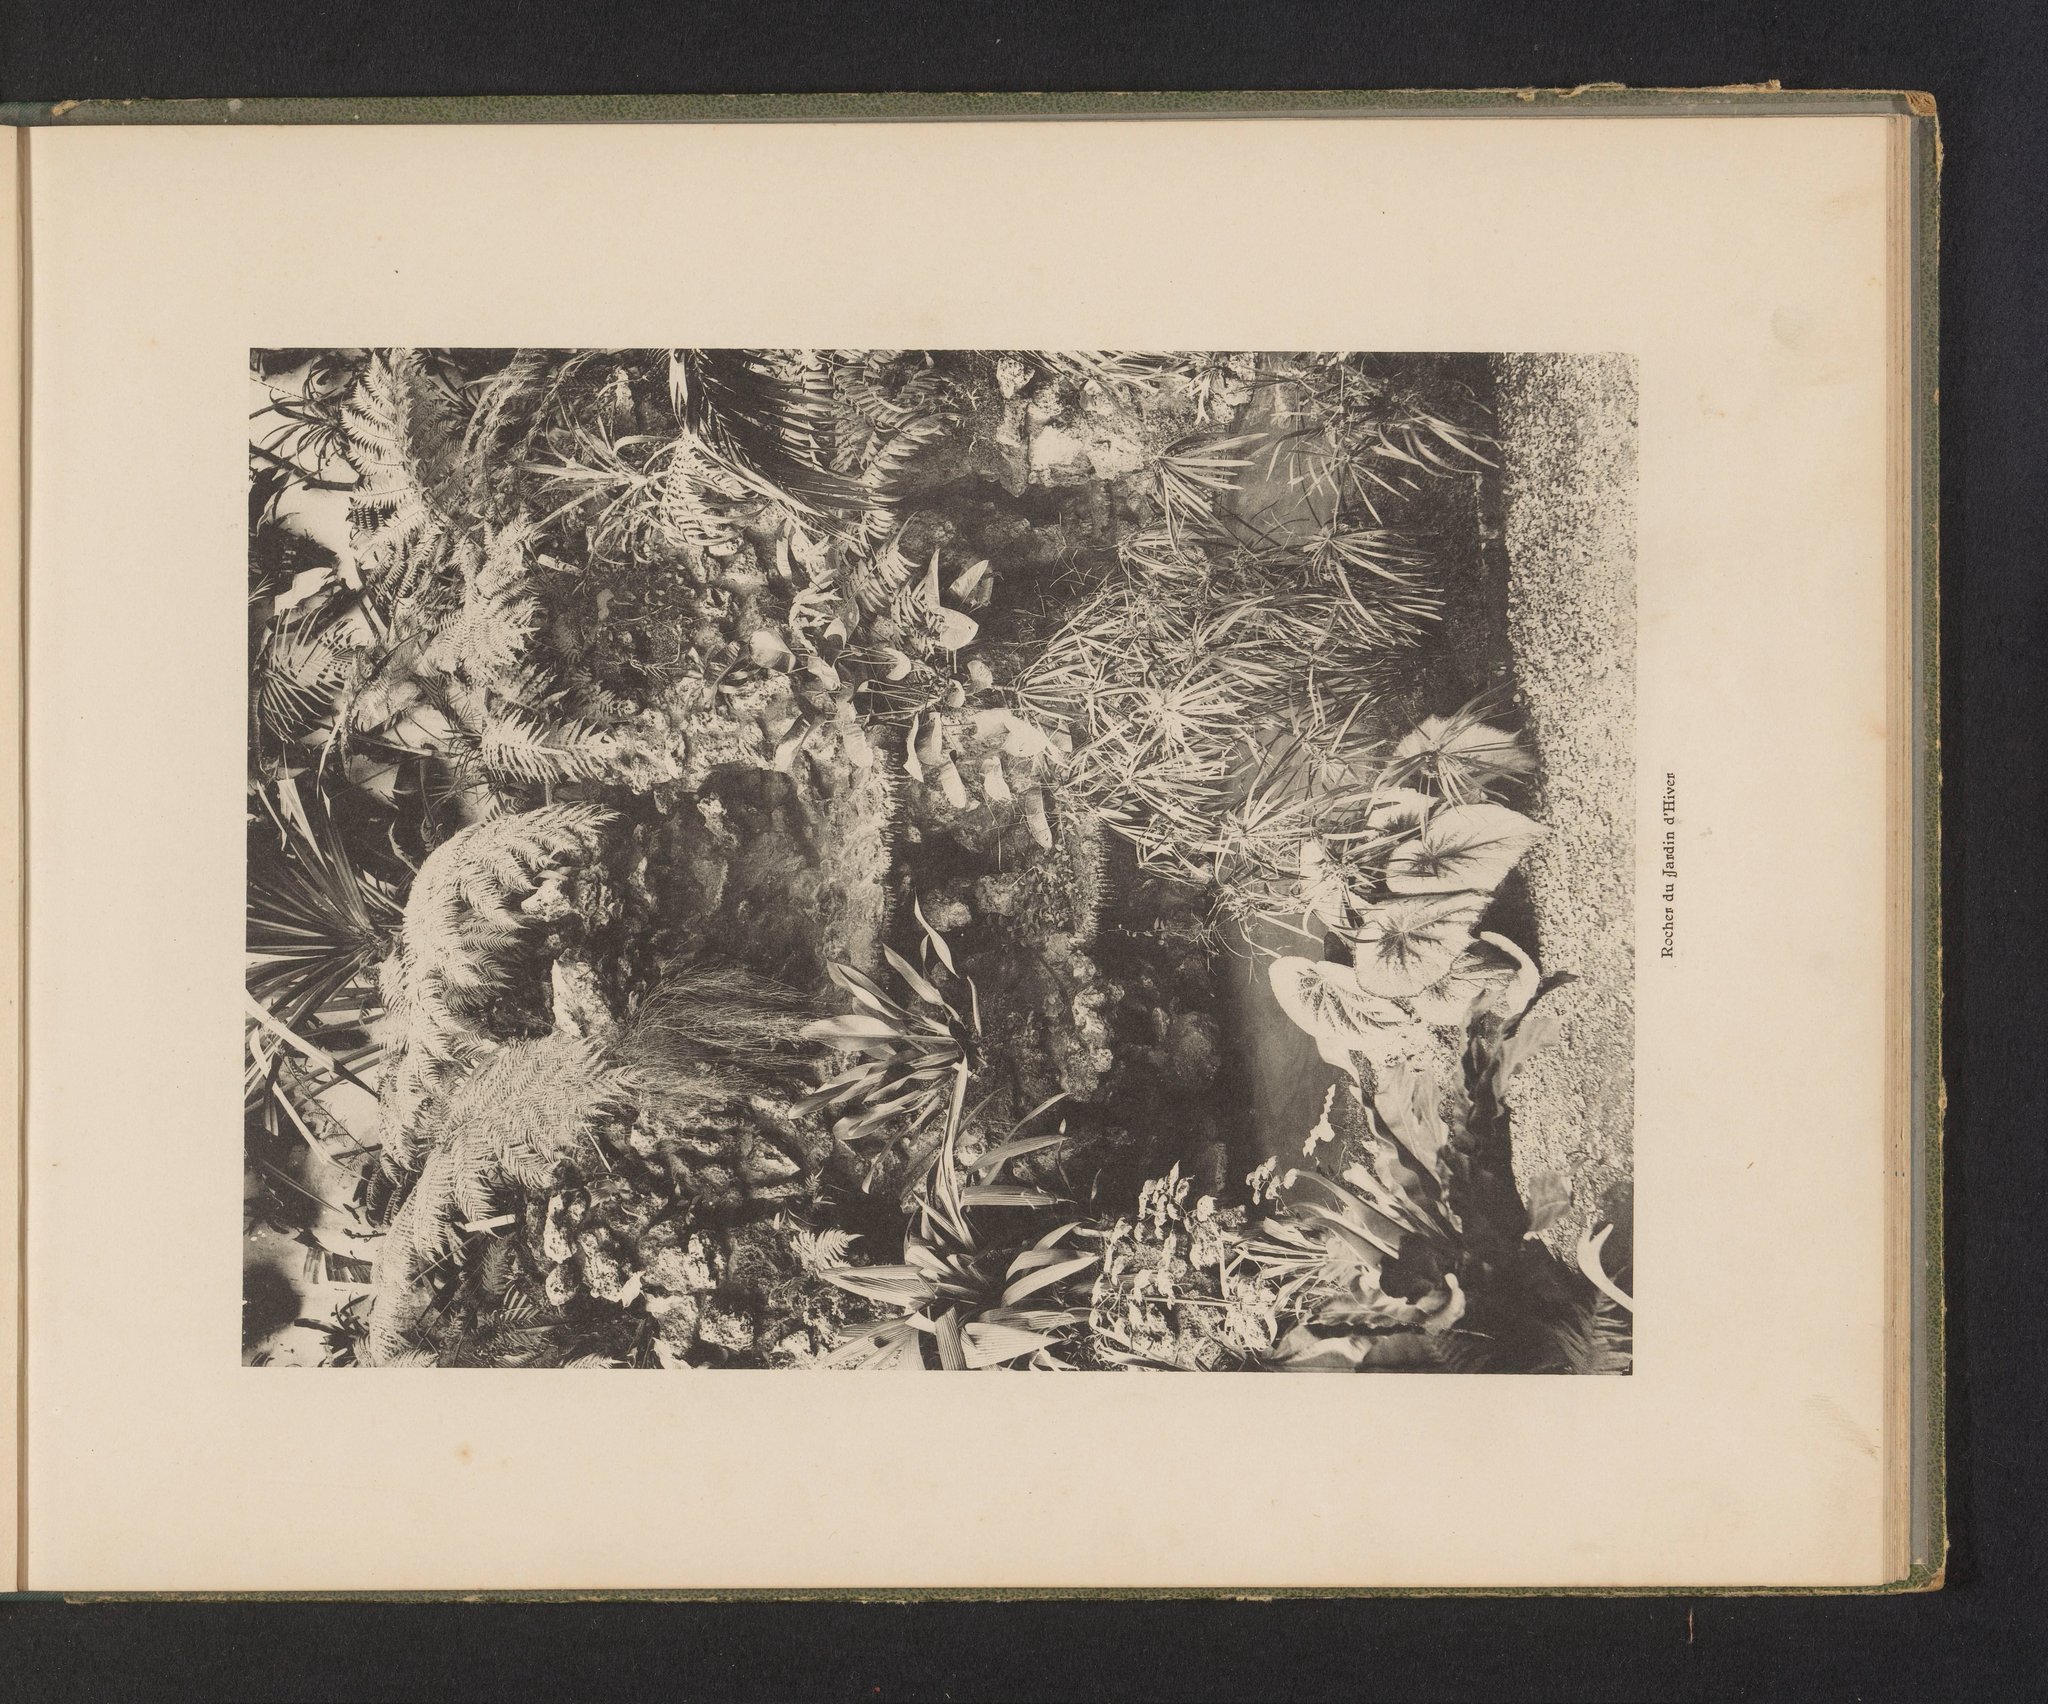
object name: photomechanical print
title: Rocher du Jardin d'Hiver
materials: paper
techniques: photograph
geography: versailles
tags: horticulture, vegetable culture, market gardening, winter-garden, conservatory